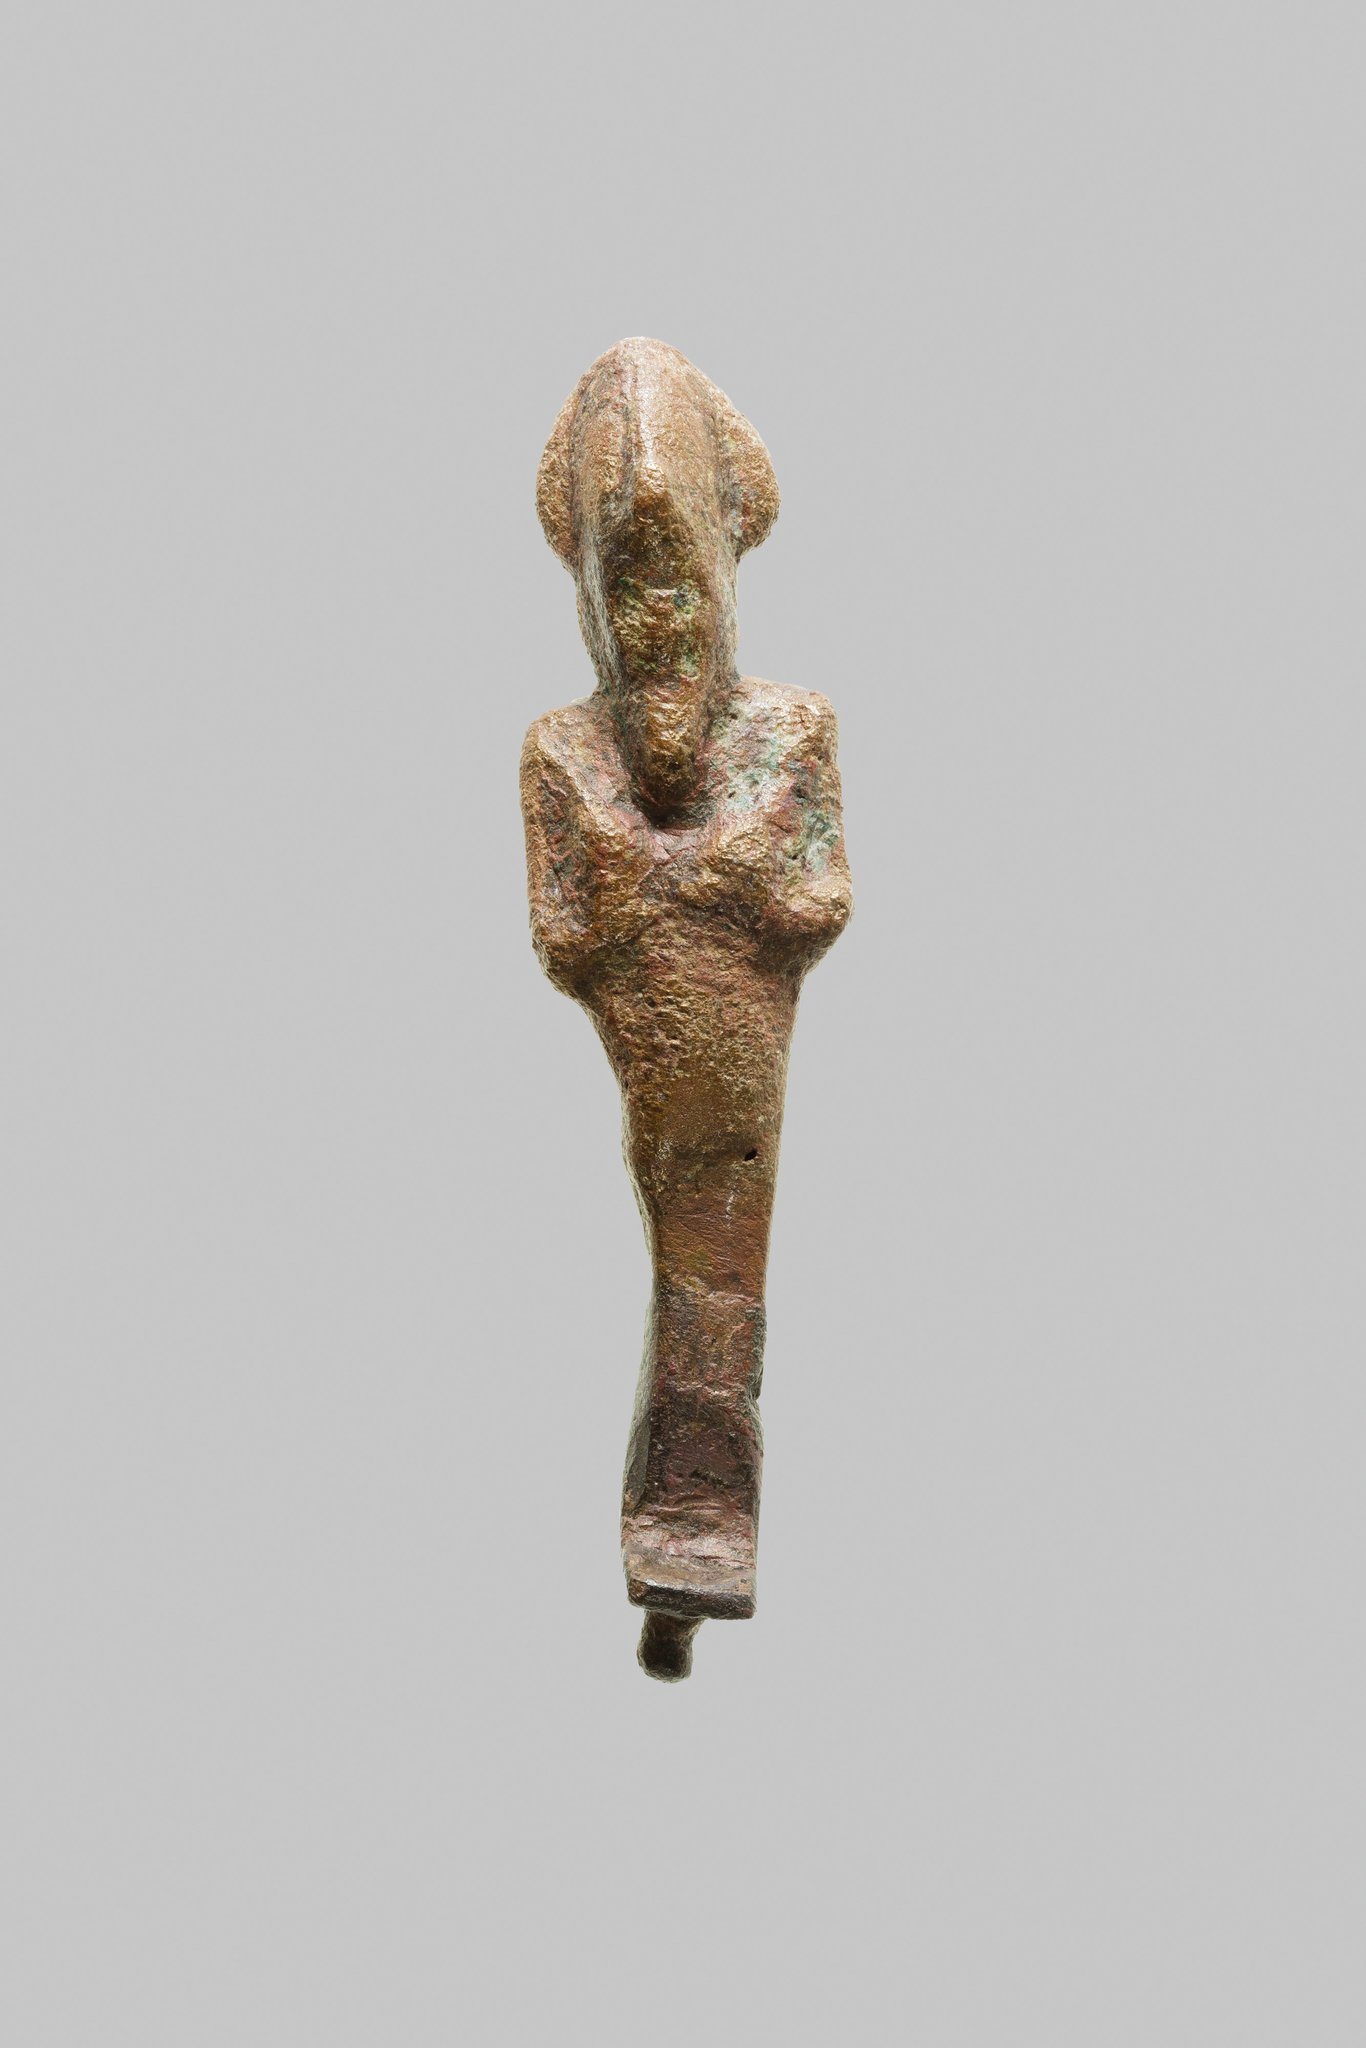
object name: statuette, osiris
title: Statuette of Osiris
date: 712-30 BCE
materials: bronze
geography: egypt